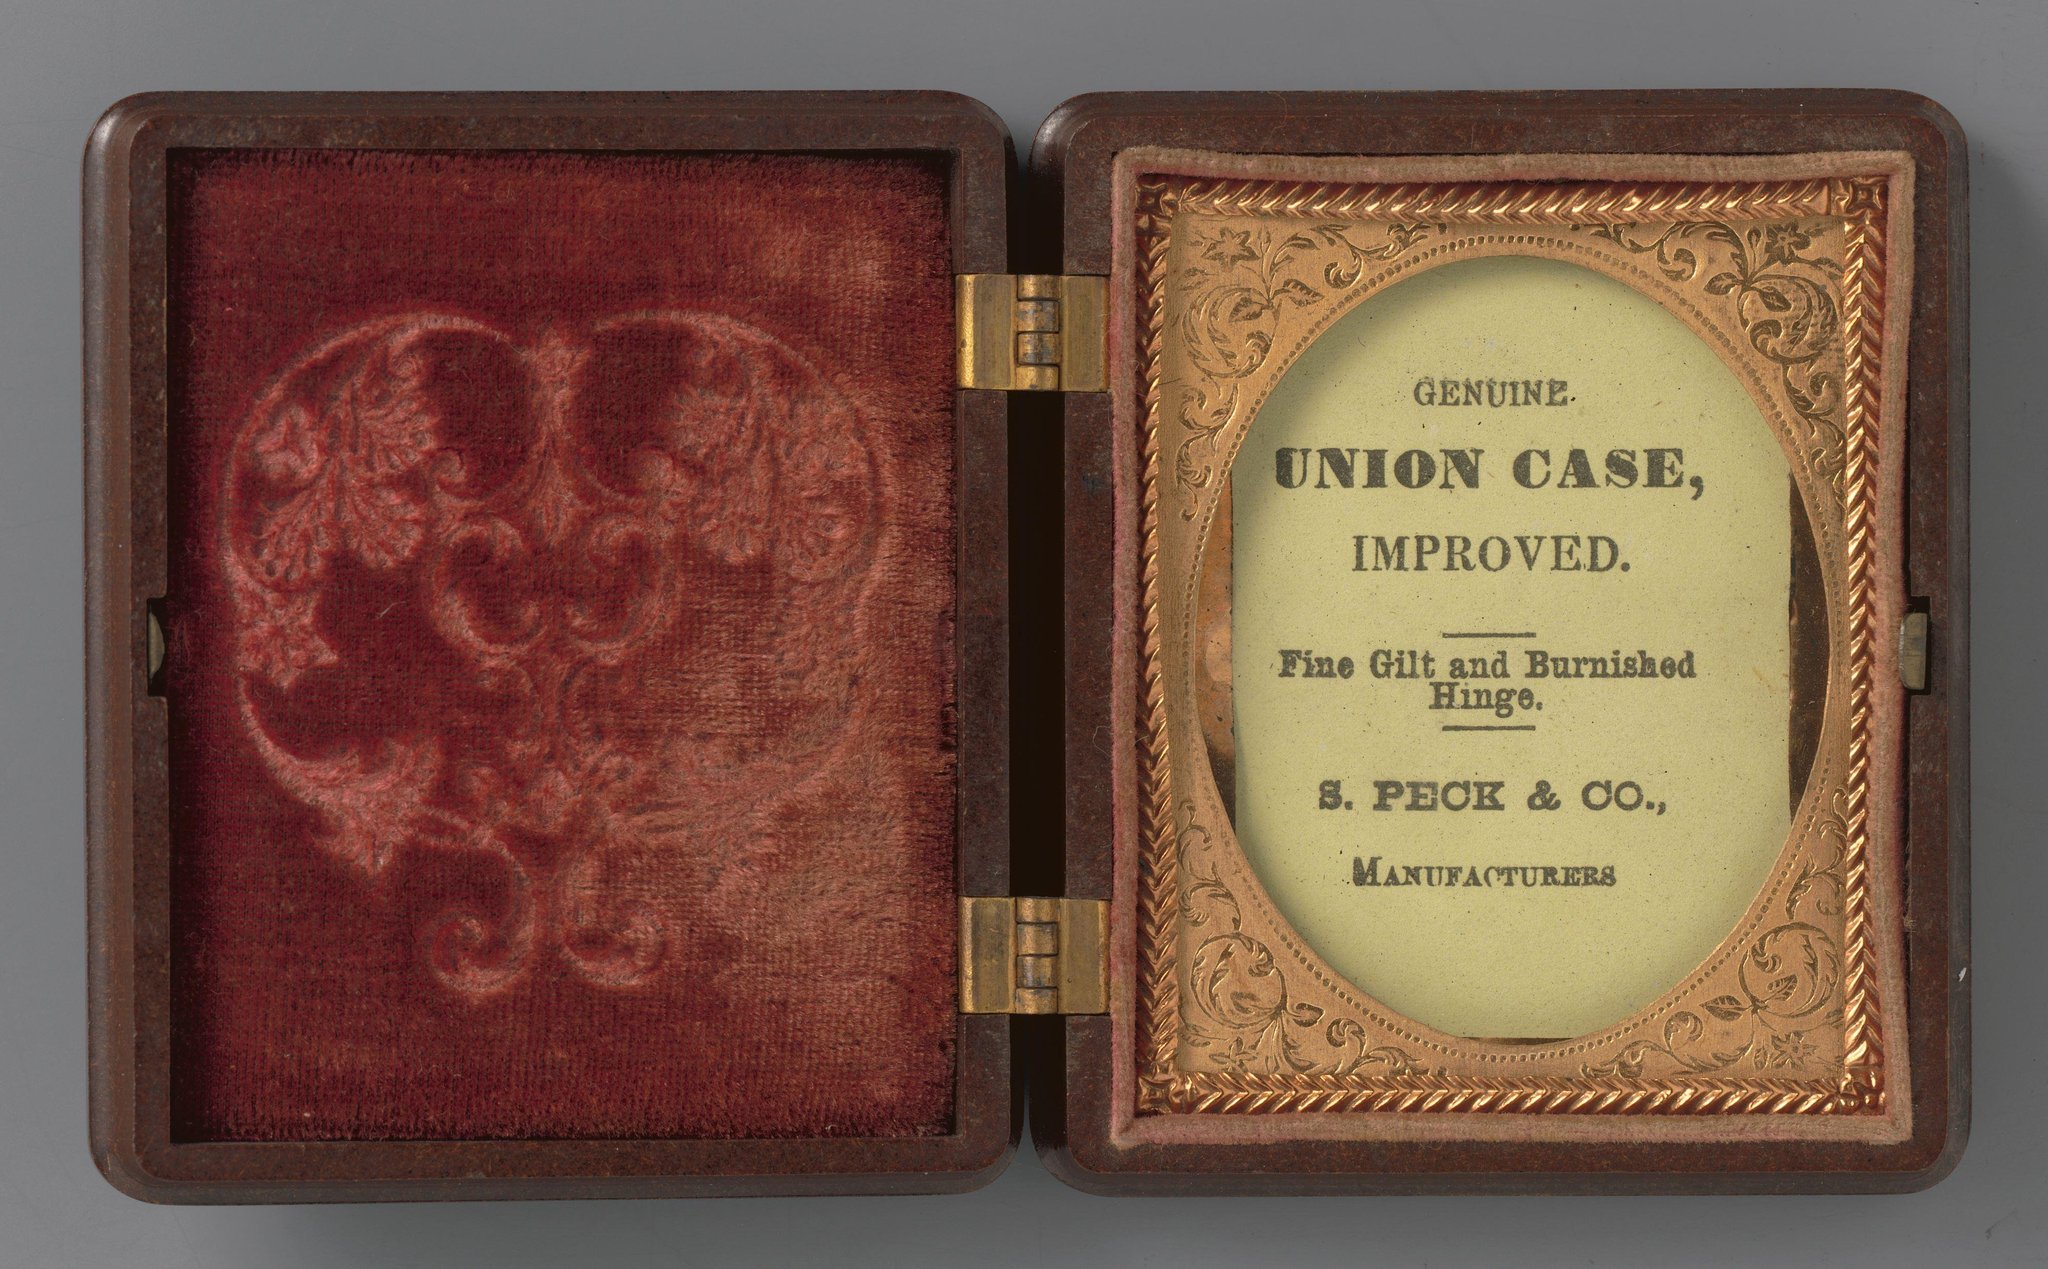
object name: union case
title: Lege union case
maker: samuel peck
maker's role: manufacturer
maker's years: 1813-1879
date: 1854-1857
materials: glass, metal, plastic, velvet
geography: new haven